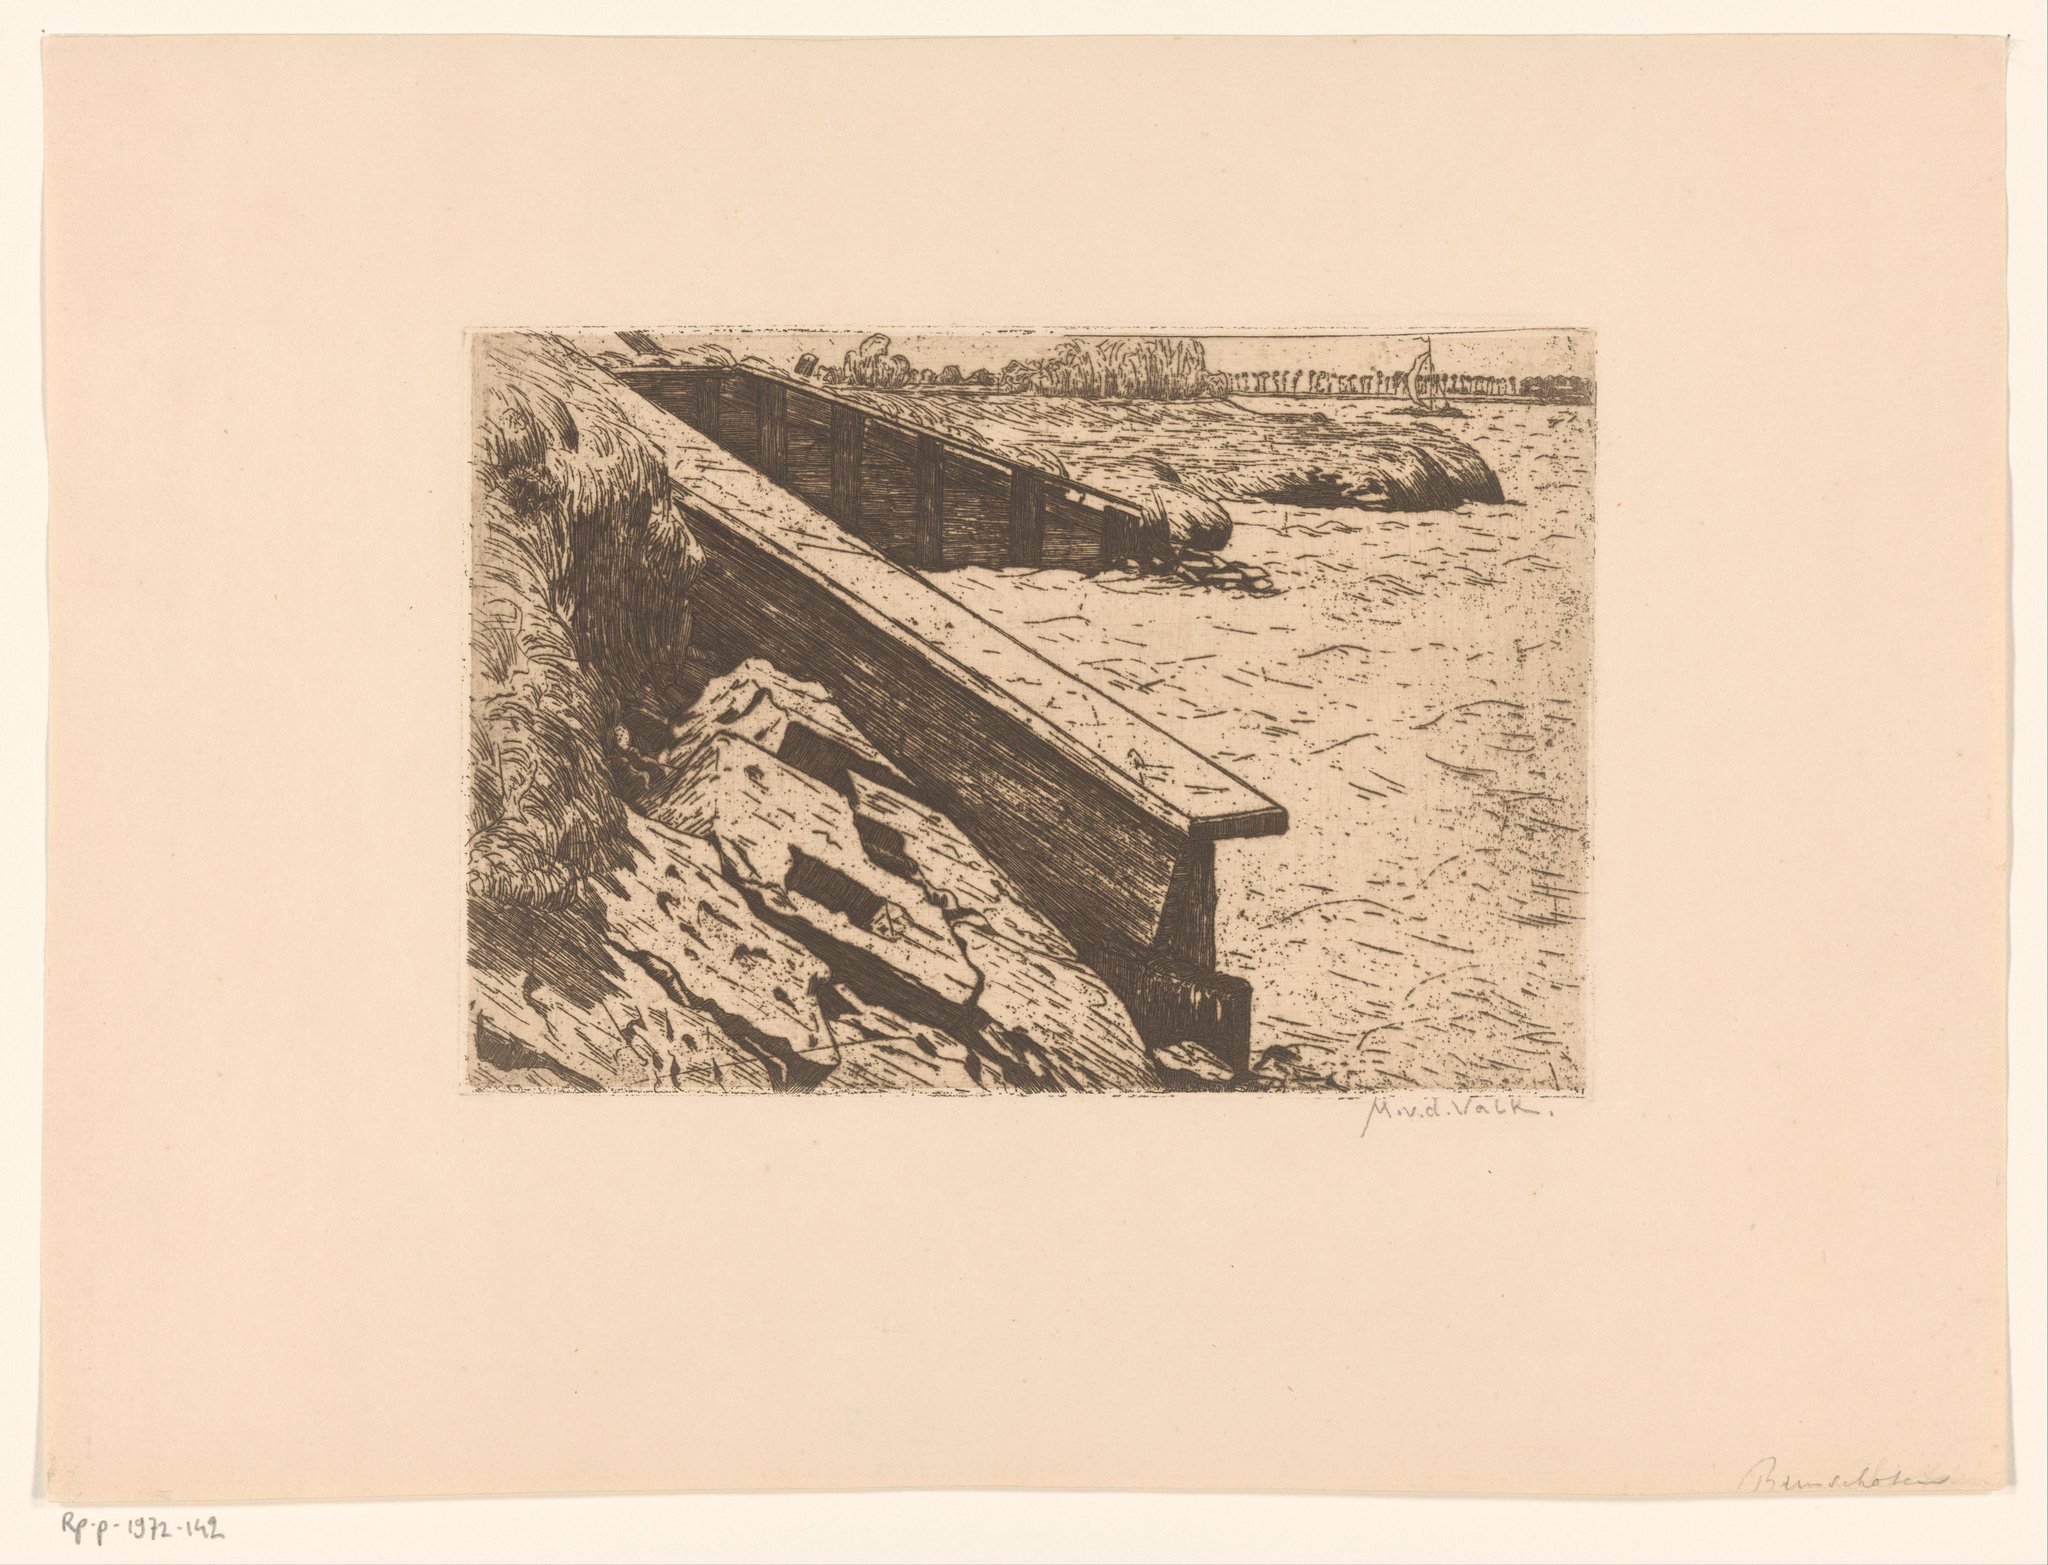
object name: print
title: Brug bij Bunschoten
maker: maurits van der valk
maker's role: draughtsman, print maker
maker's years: 1857-1935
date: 1867-1935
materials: paper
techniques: drypoint, etching, intaglio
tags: bridge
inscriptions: collector's mark: Lugt 2228, collector's mark: Lugt 2760